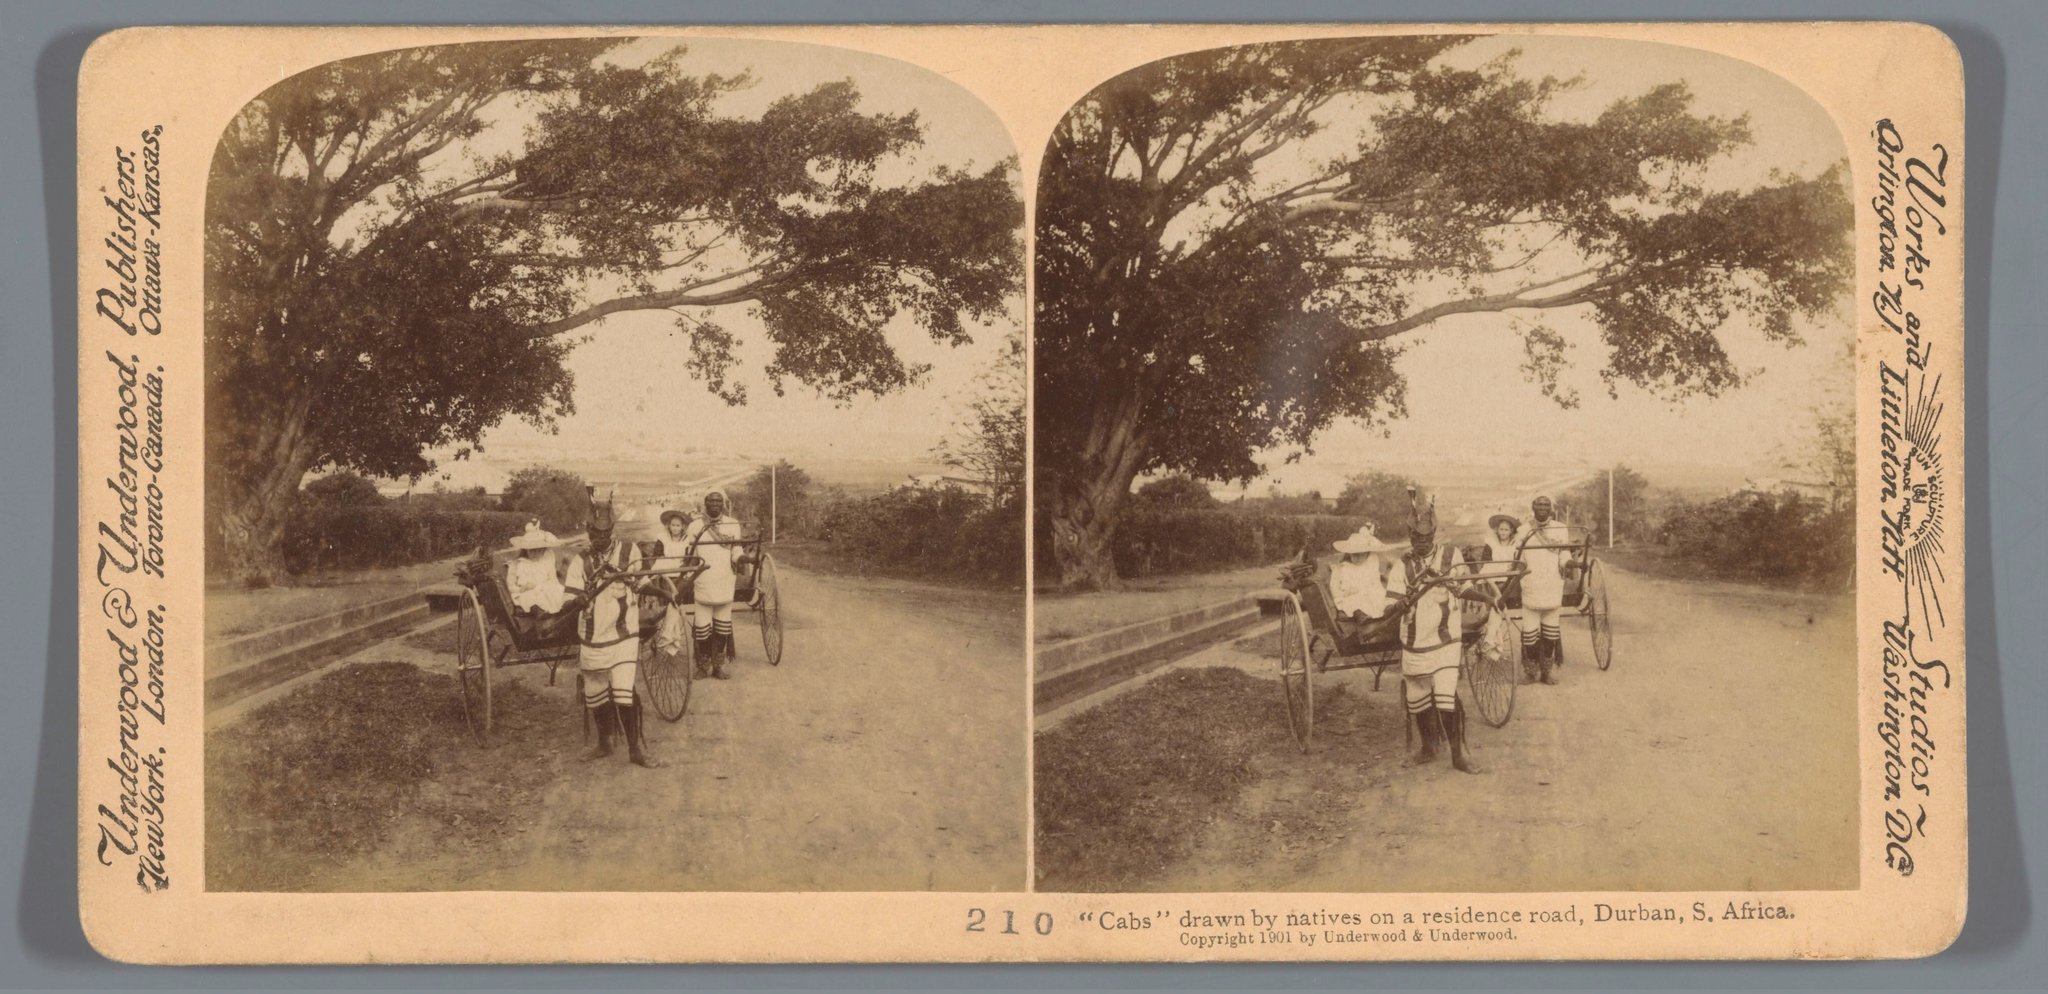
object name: stereograph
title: Twee handkarren met meisjes erop op een weg in Durban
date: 1901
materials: cardboard, photographic support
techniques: albumen print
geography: durban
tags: hand-cart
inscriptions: number: ‘210’, name: ‘Works and Studios Sun Sculpture trade mark Arlington N.J. Littleton N.H. Washington D.C.’